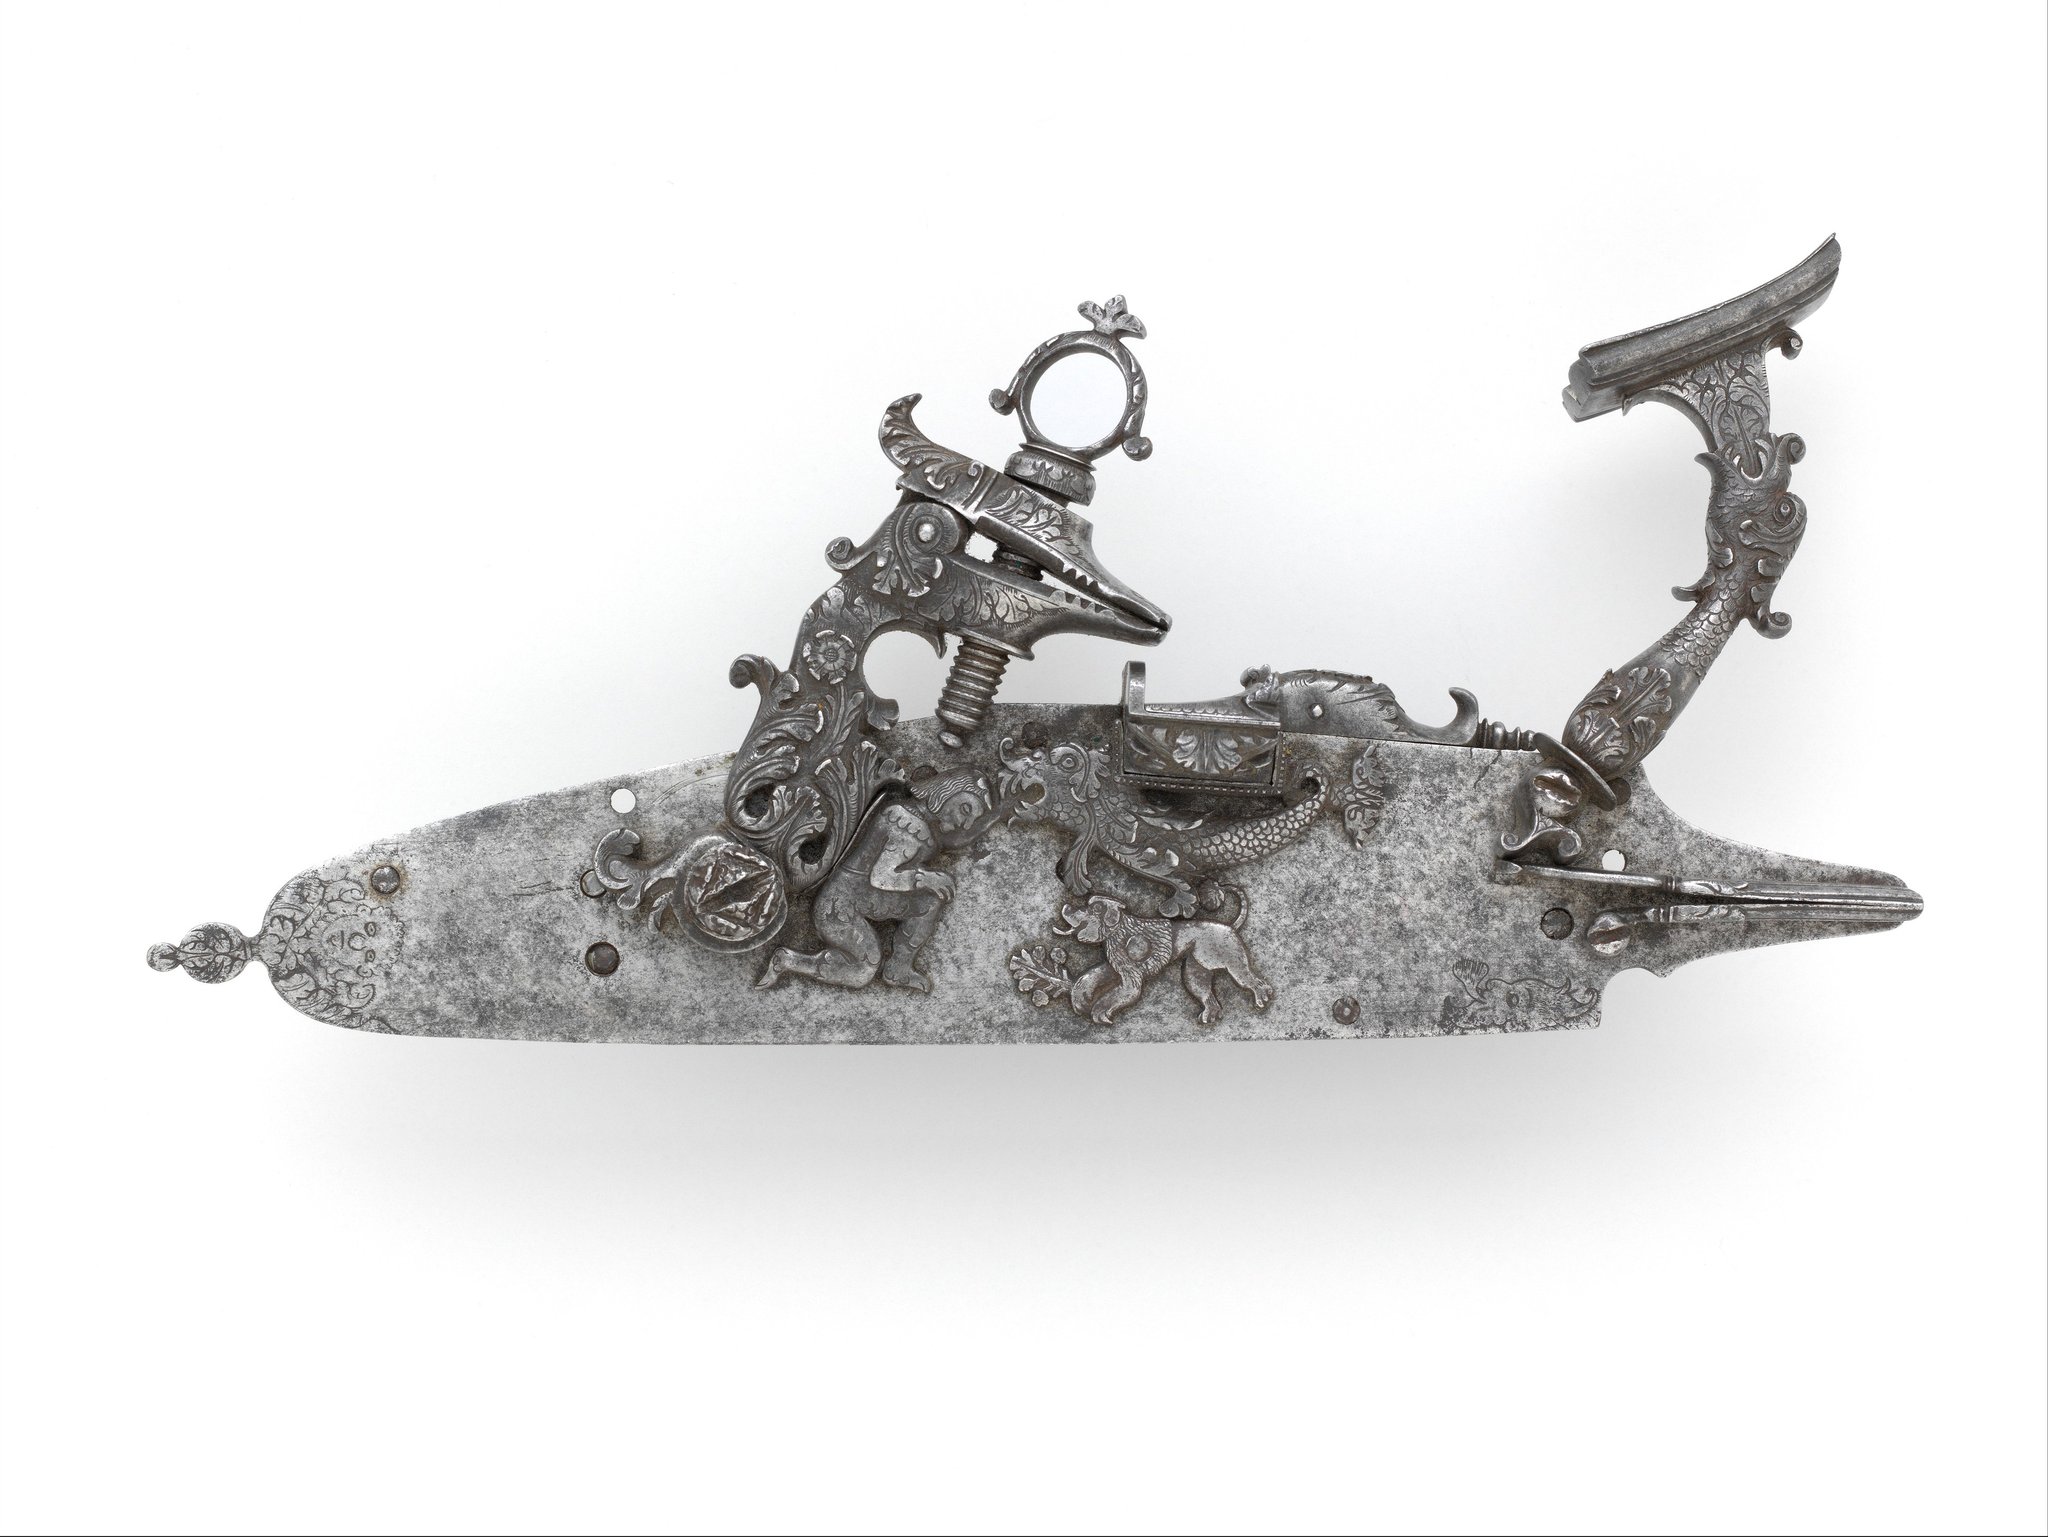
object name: snaphaunce lock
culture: italian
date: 1601-1700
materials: iron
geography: italy